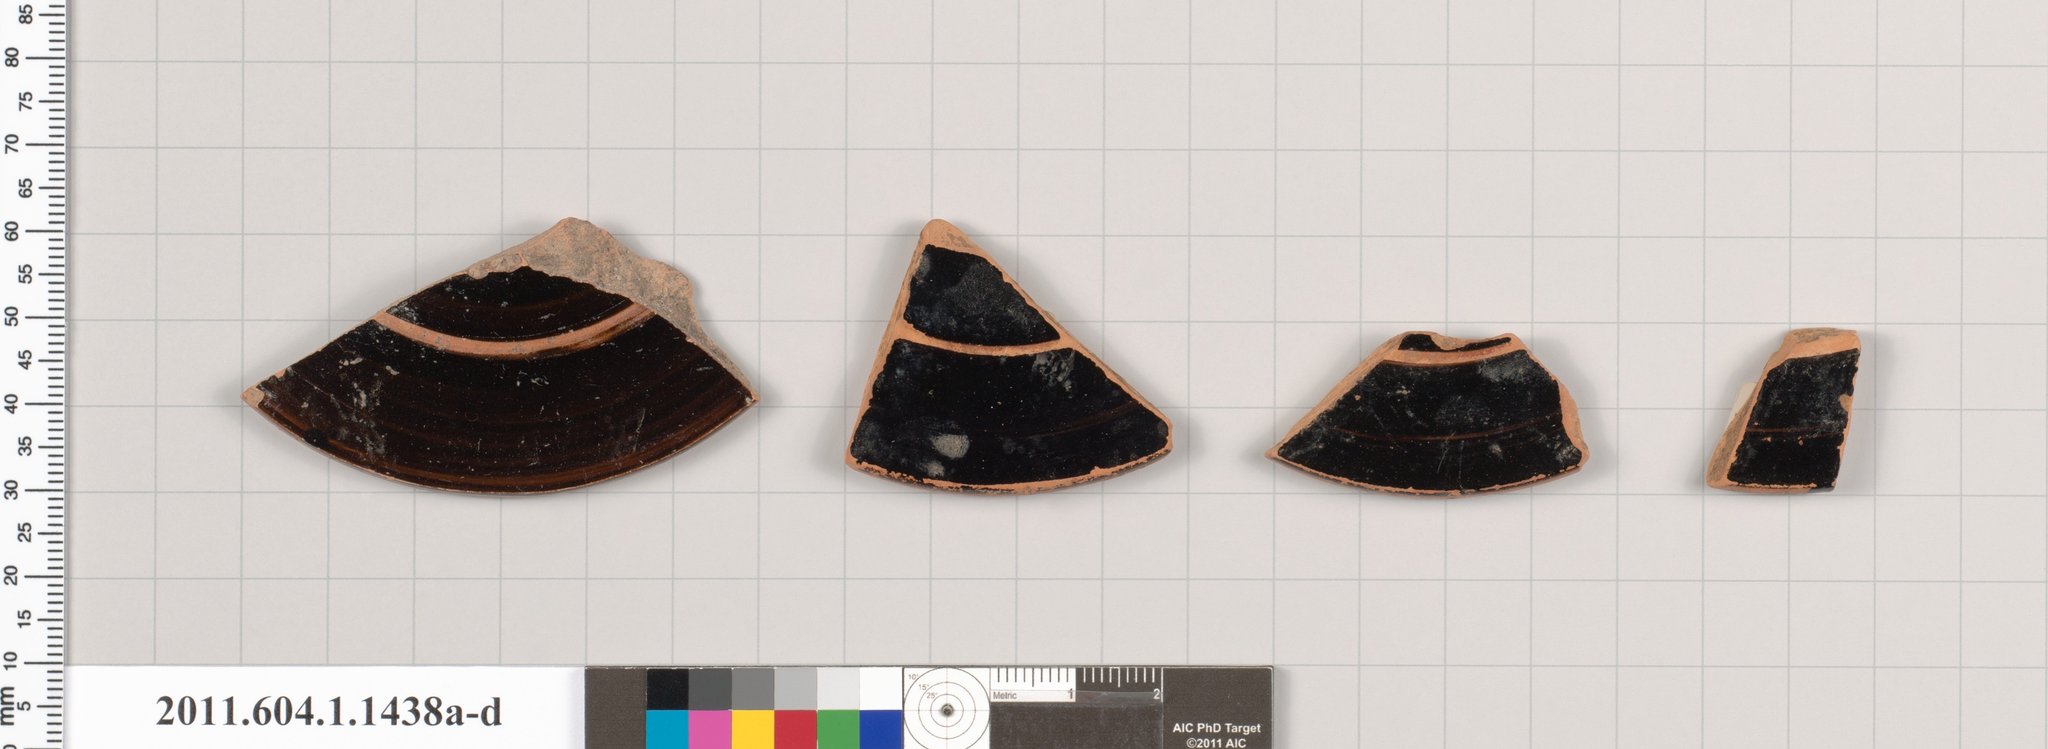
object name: kylix fragment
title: Terracotta fragments of kylikes (drinking cups)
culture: greek, attic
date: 500-401 BCE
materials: terracotta